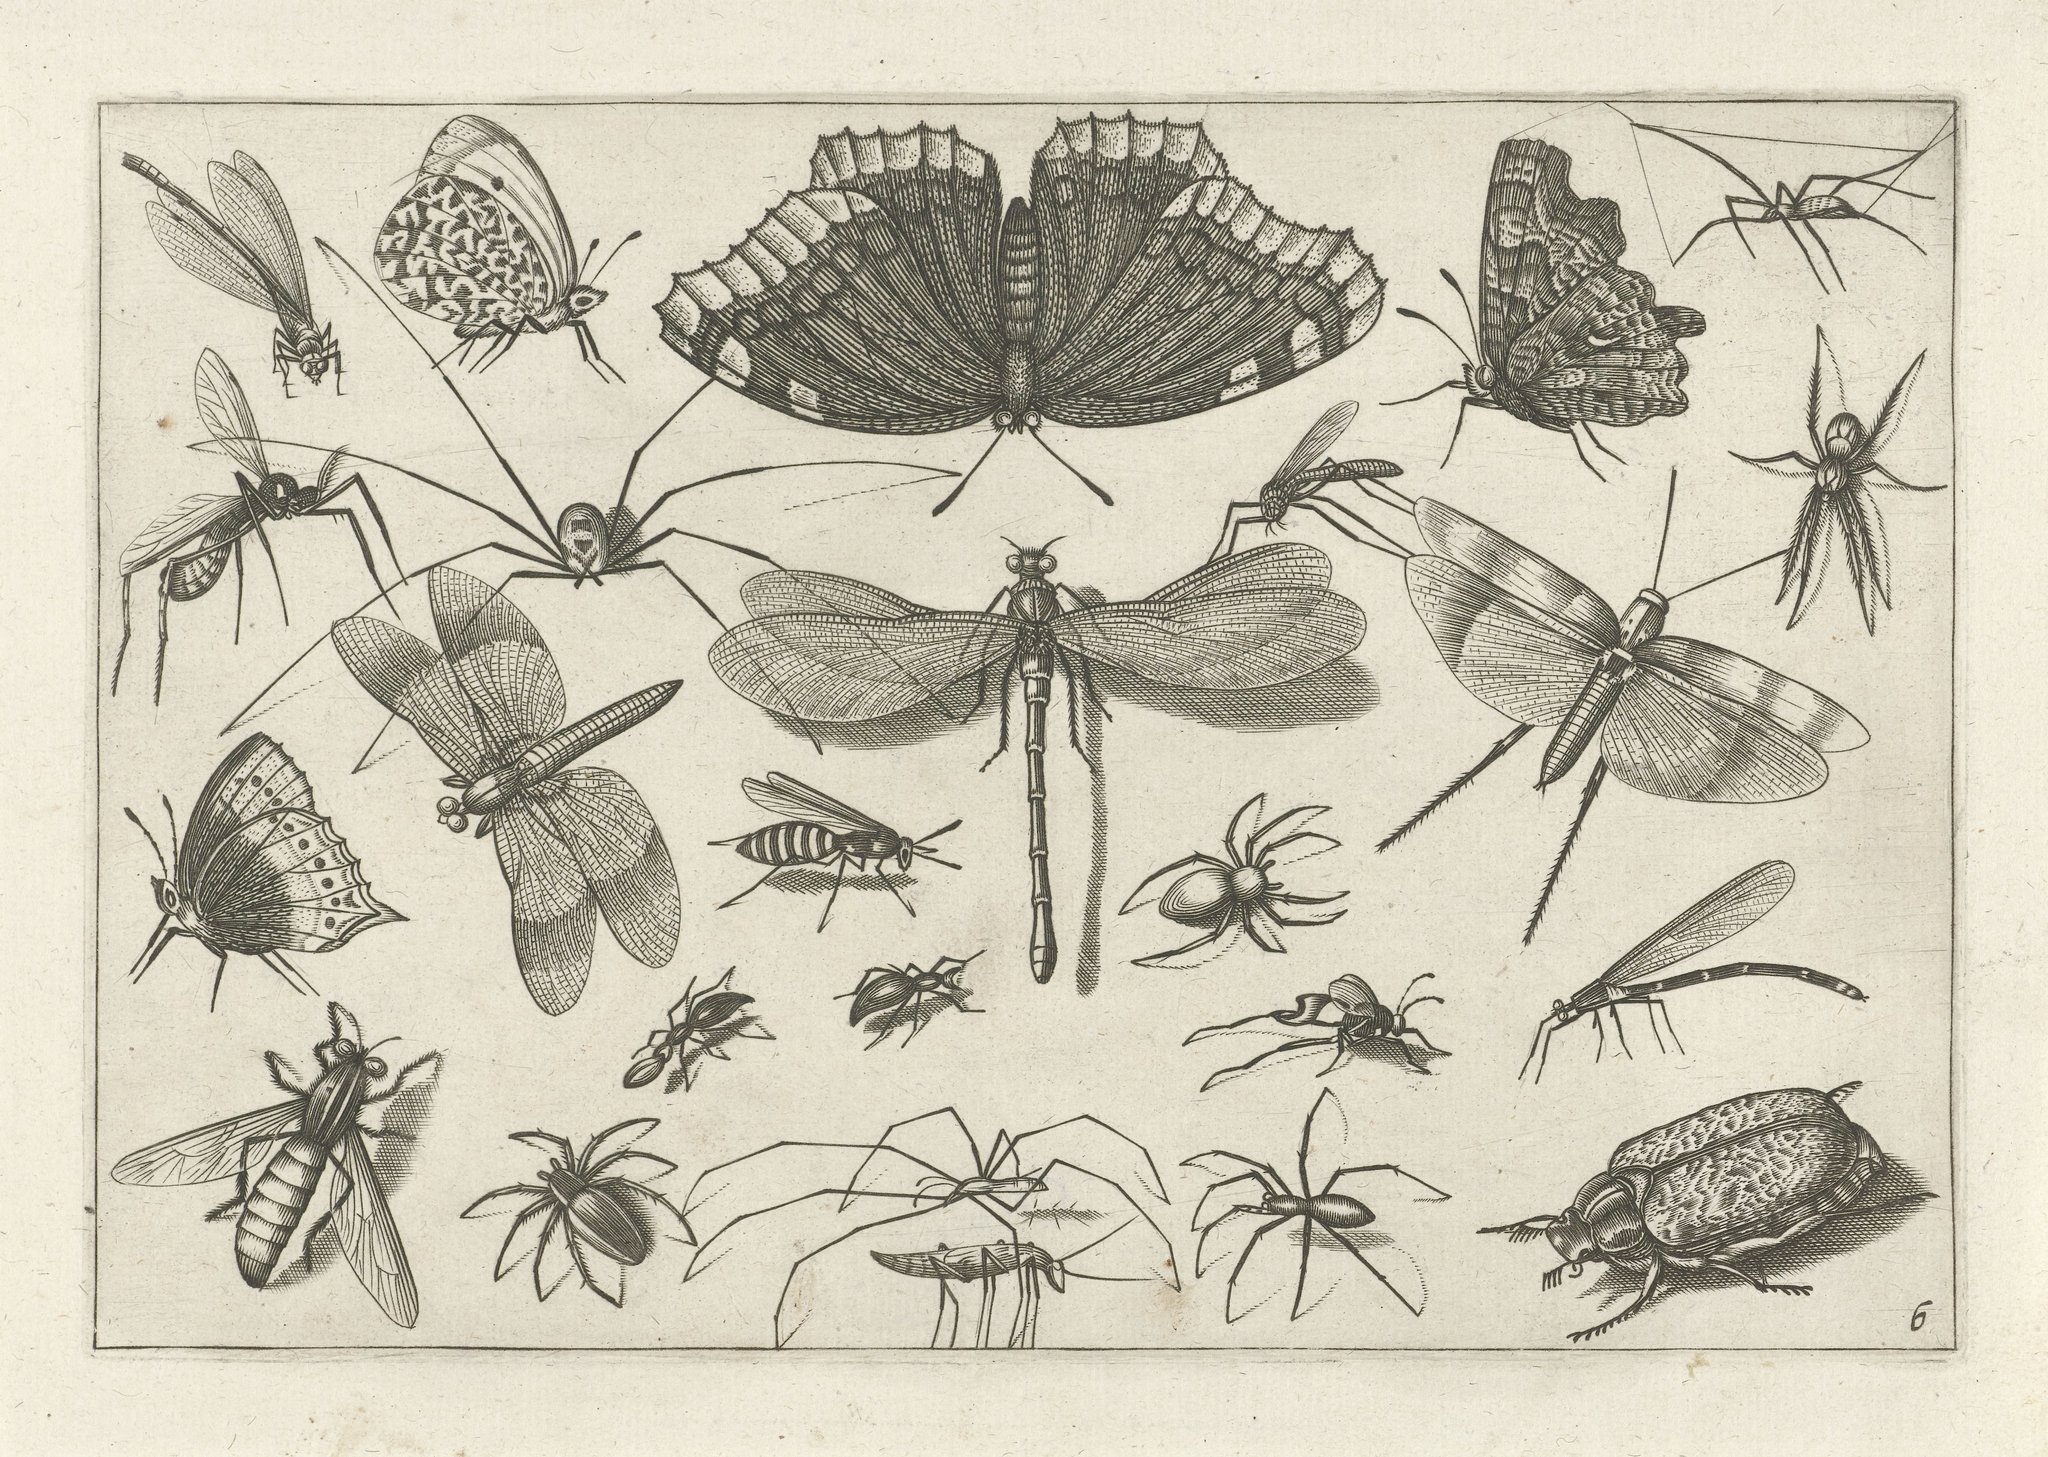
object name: print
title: Diversae Insectarum Volatilium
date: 1630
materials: paper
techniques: engraving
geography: amsterdam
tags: insects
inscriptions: collector's mark: Lugt 2228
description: Verschillende insecten met middenboven een rouwmantel.